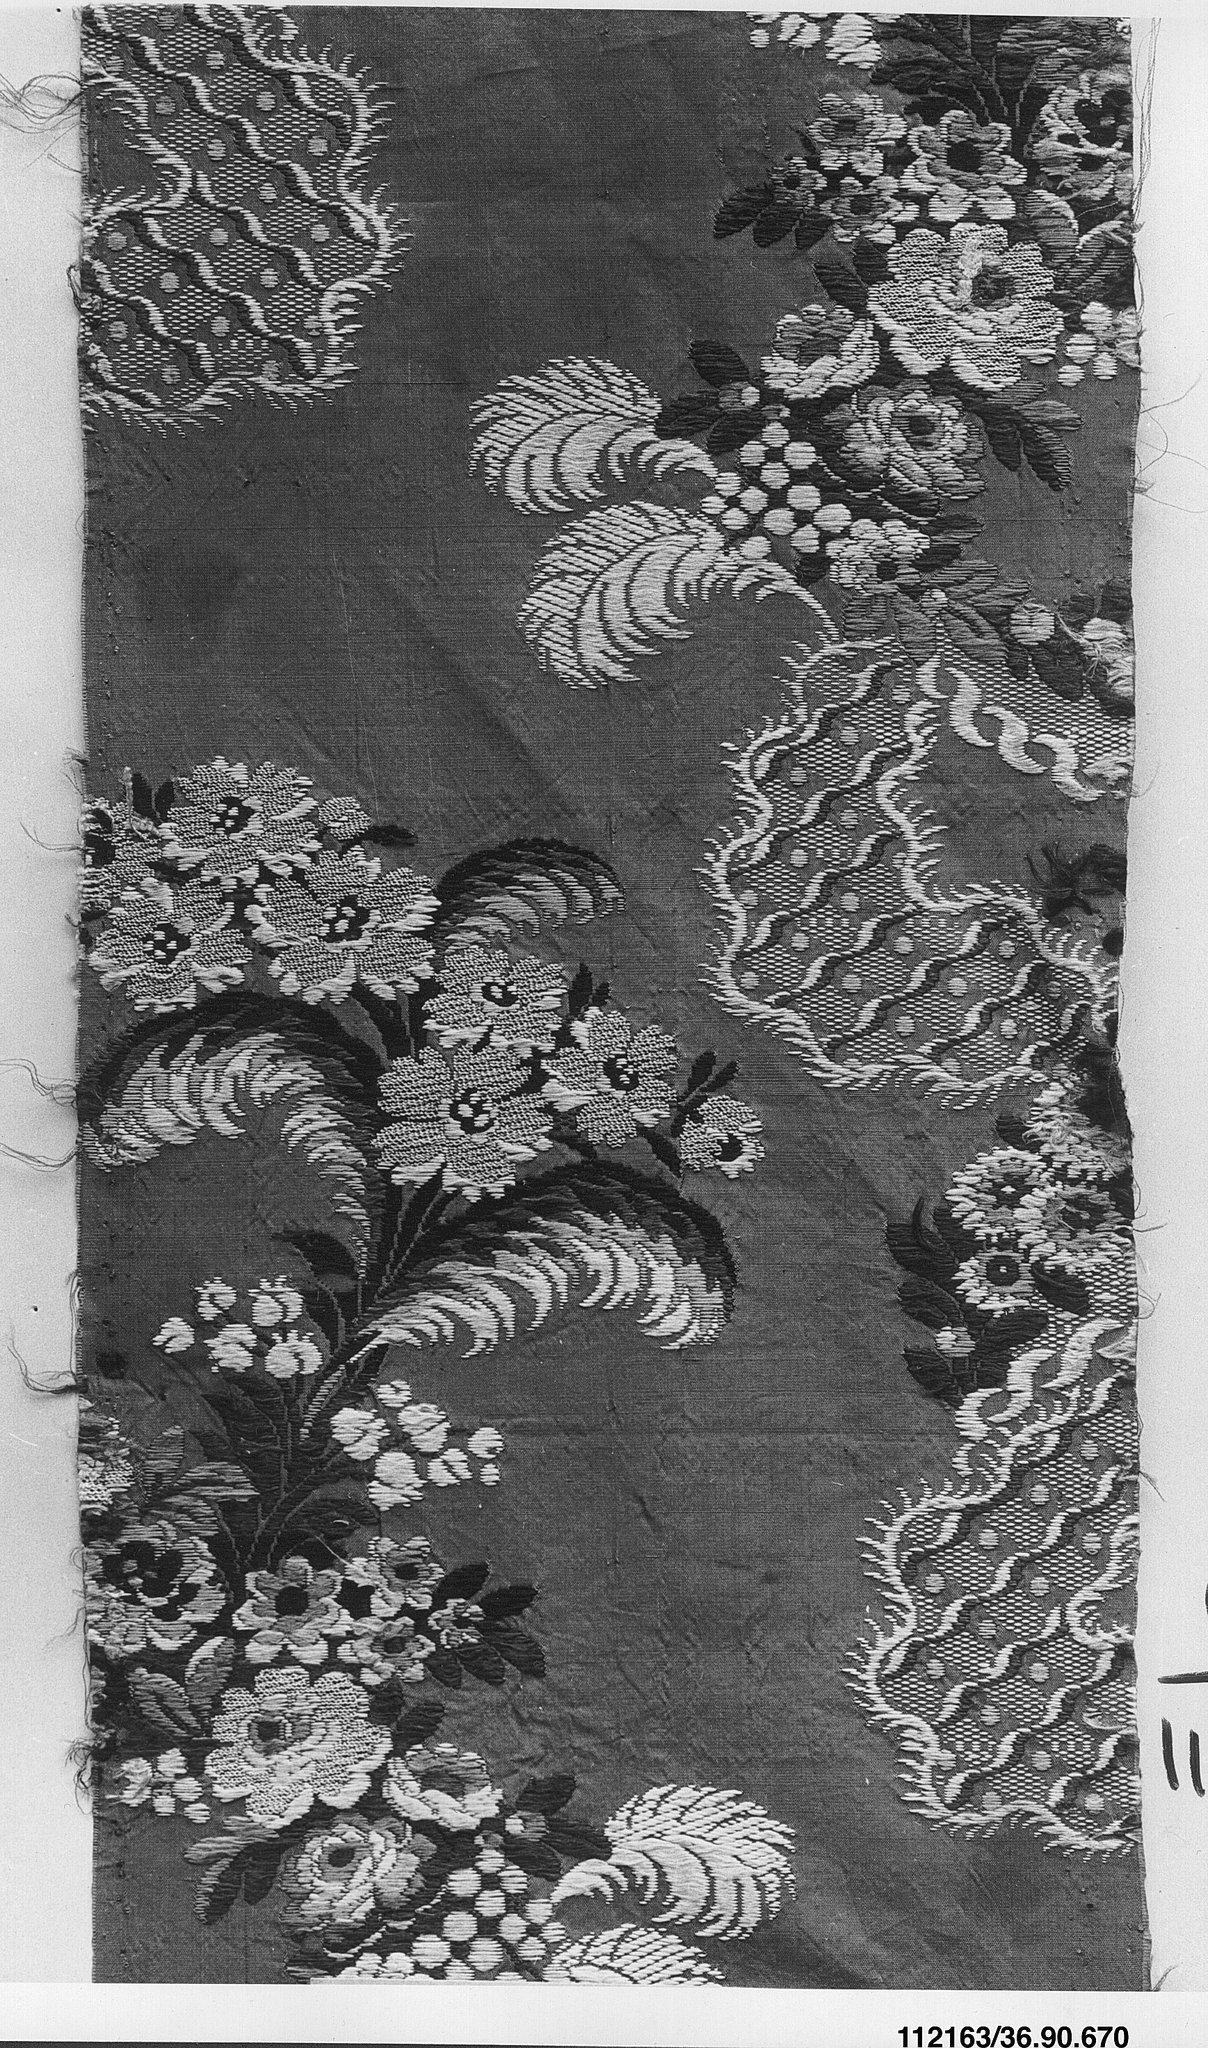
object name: piece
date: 1750-1760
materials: silk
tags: flowers